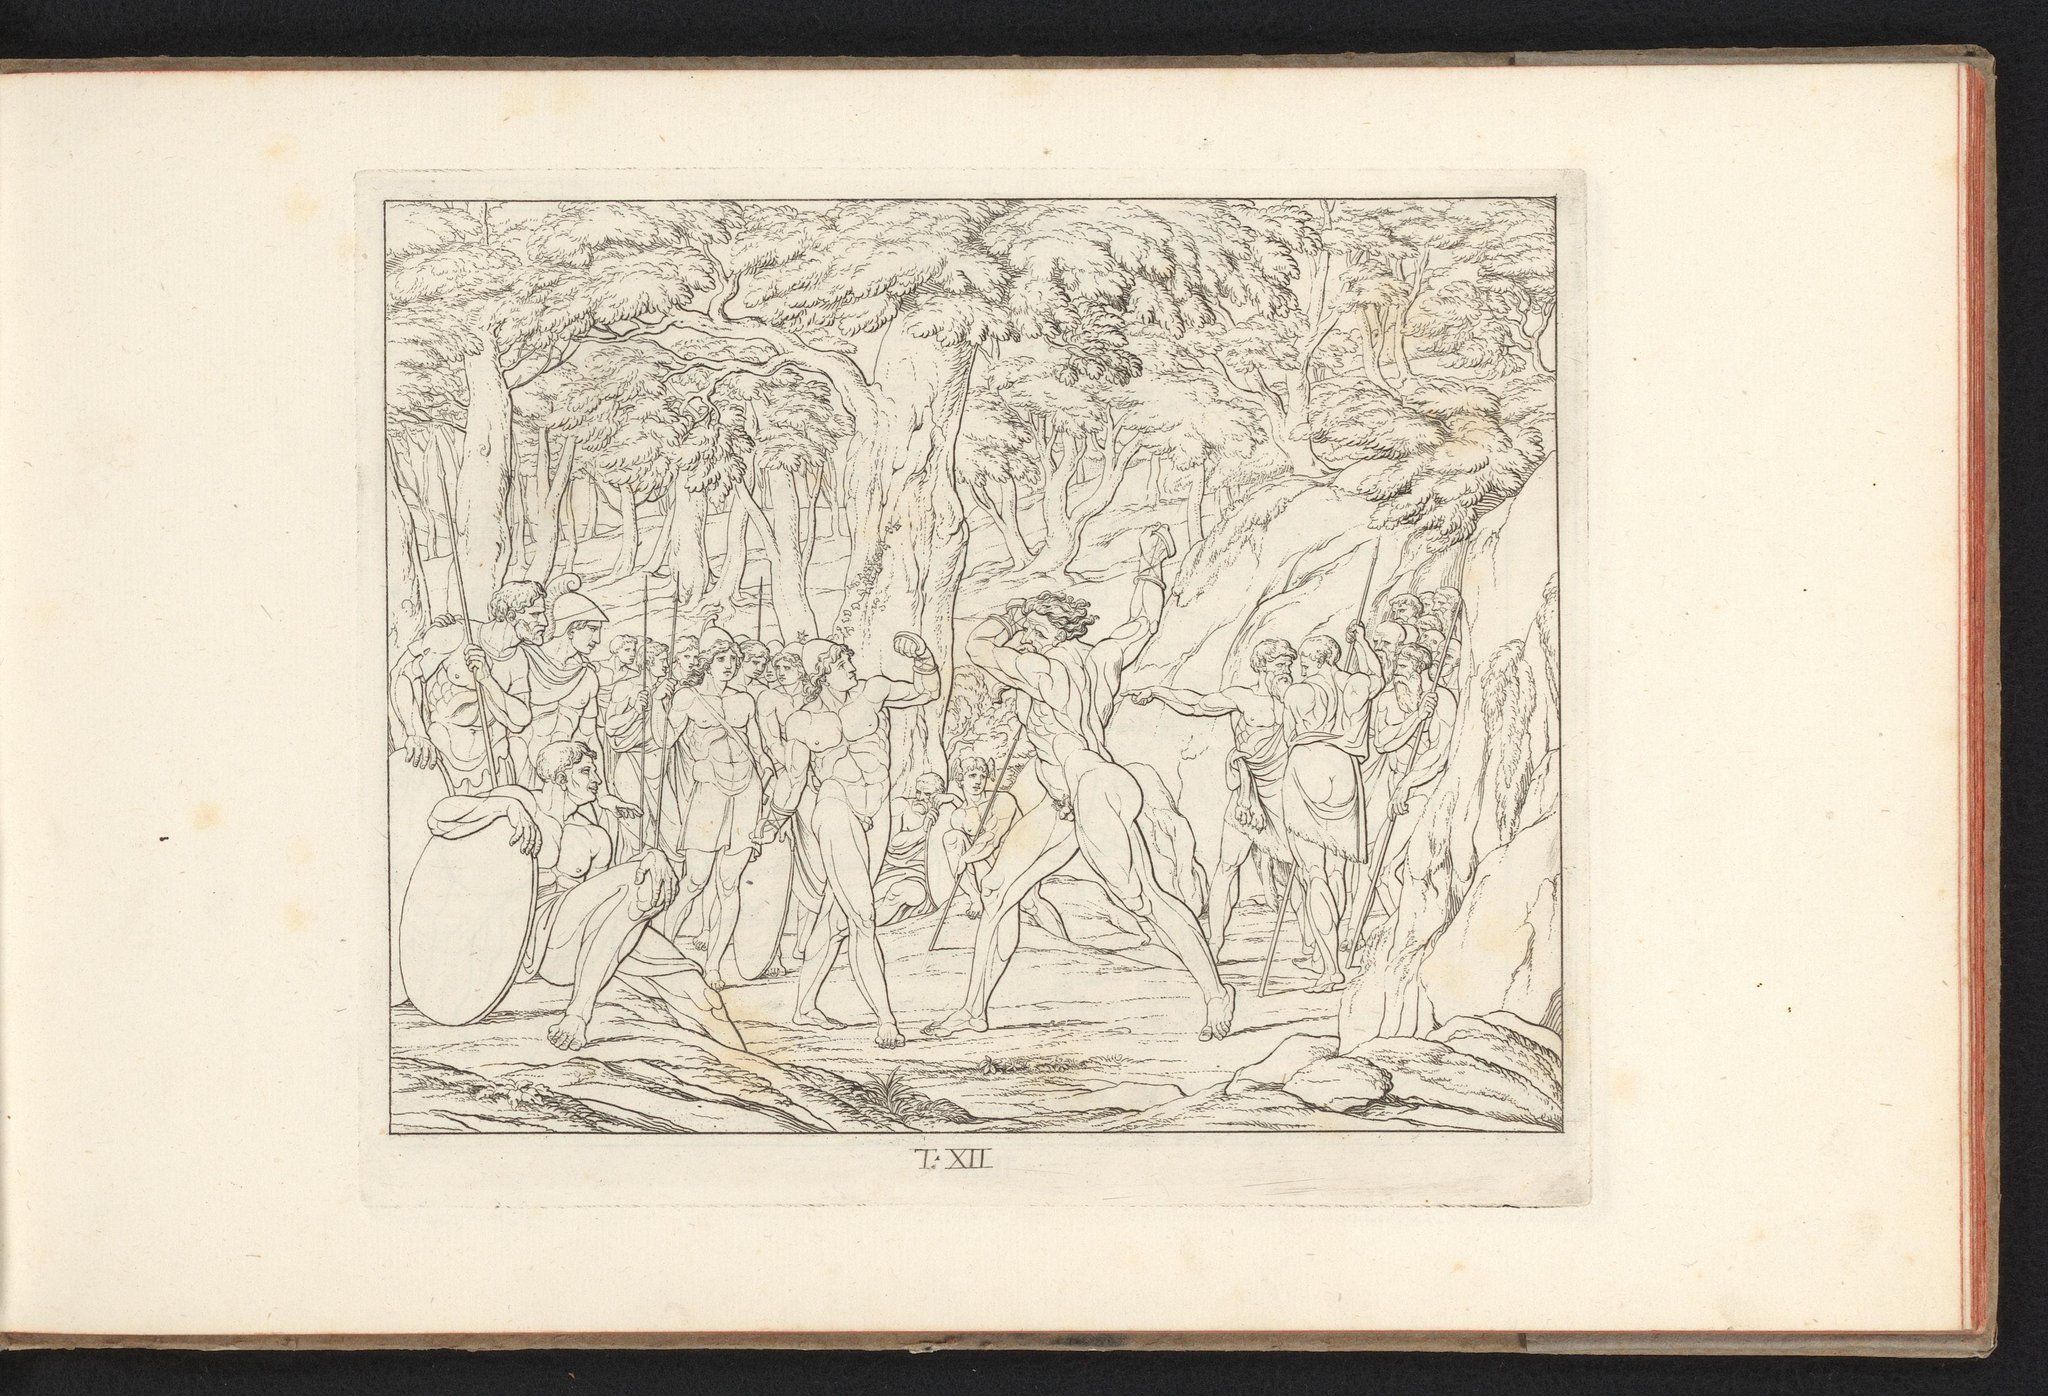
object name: print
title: Pollux in gevecht met Amycus, koning van de Bebrykers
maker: joseph anton koch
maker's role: draughtsman, painter, print maker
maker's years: 1768-1839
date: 1799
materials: paper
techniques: etching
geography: rome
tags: boxing-match between the bebrycian king amycus and pollux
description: Deze prent maakt deel uit van een serie met 24 prenten.